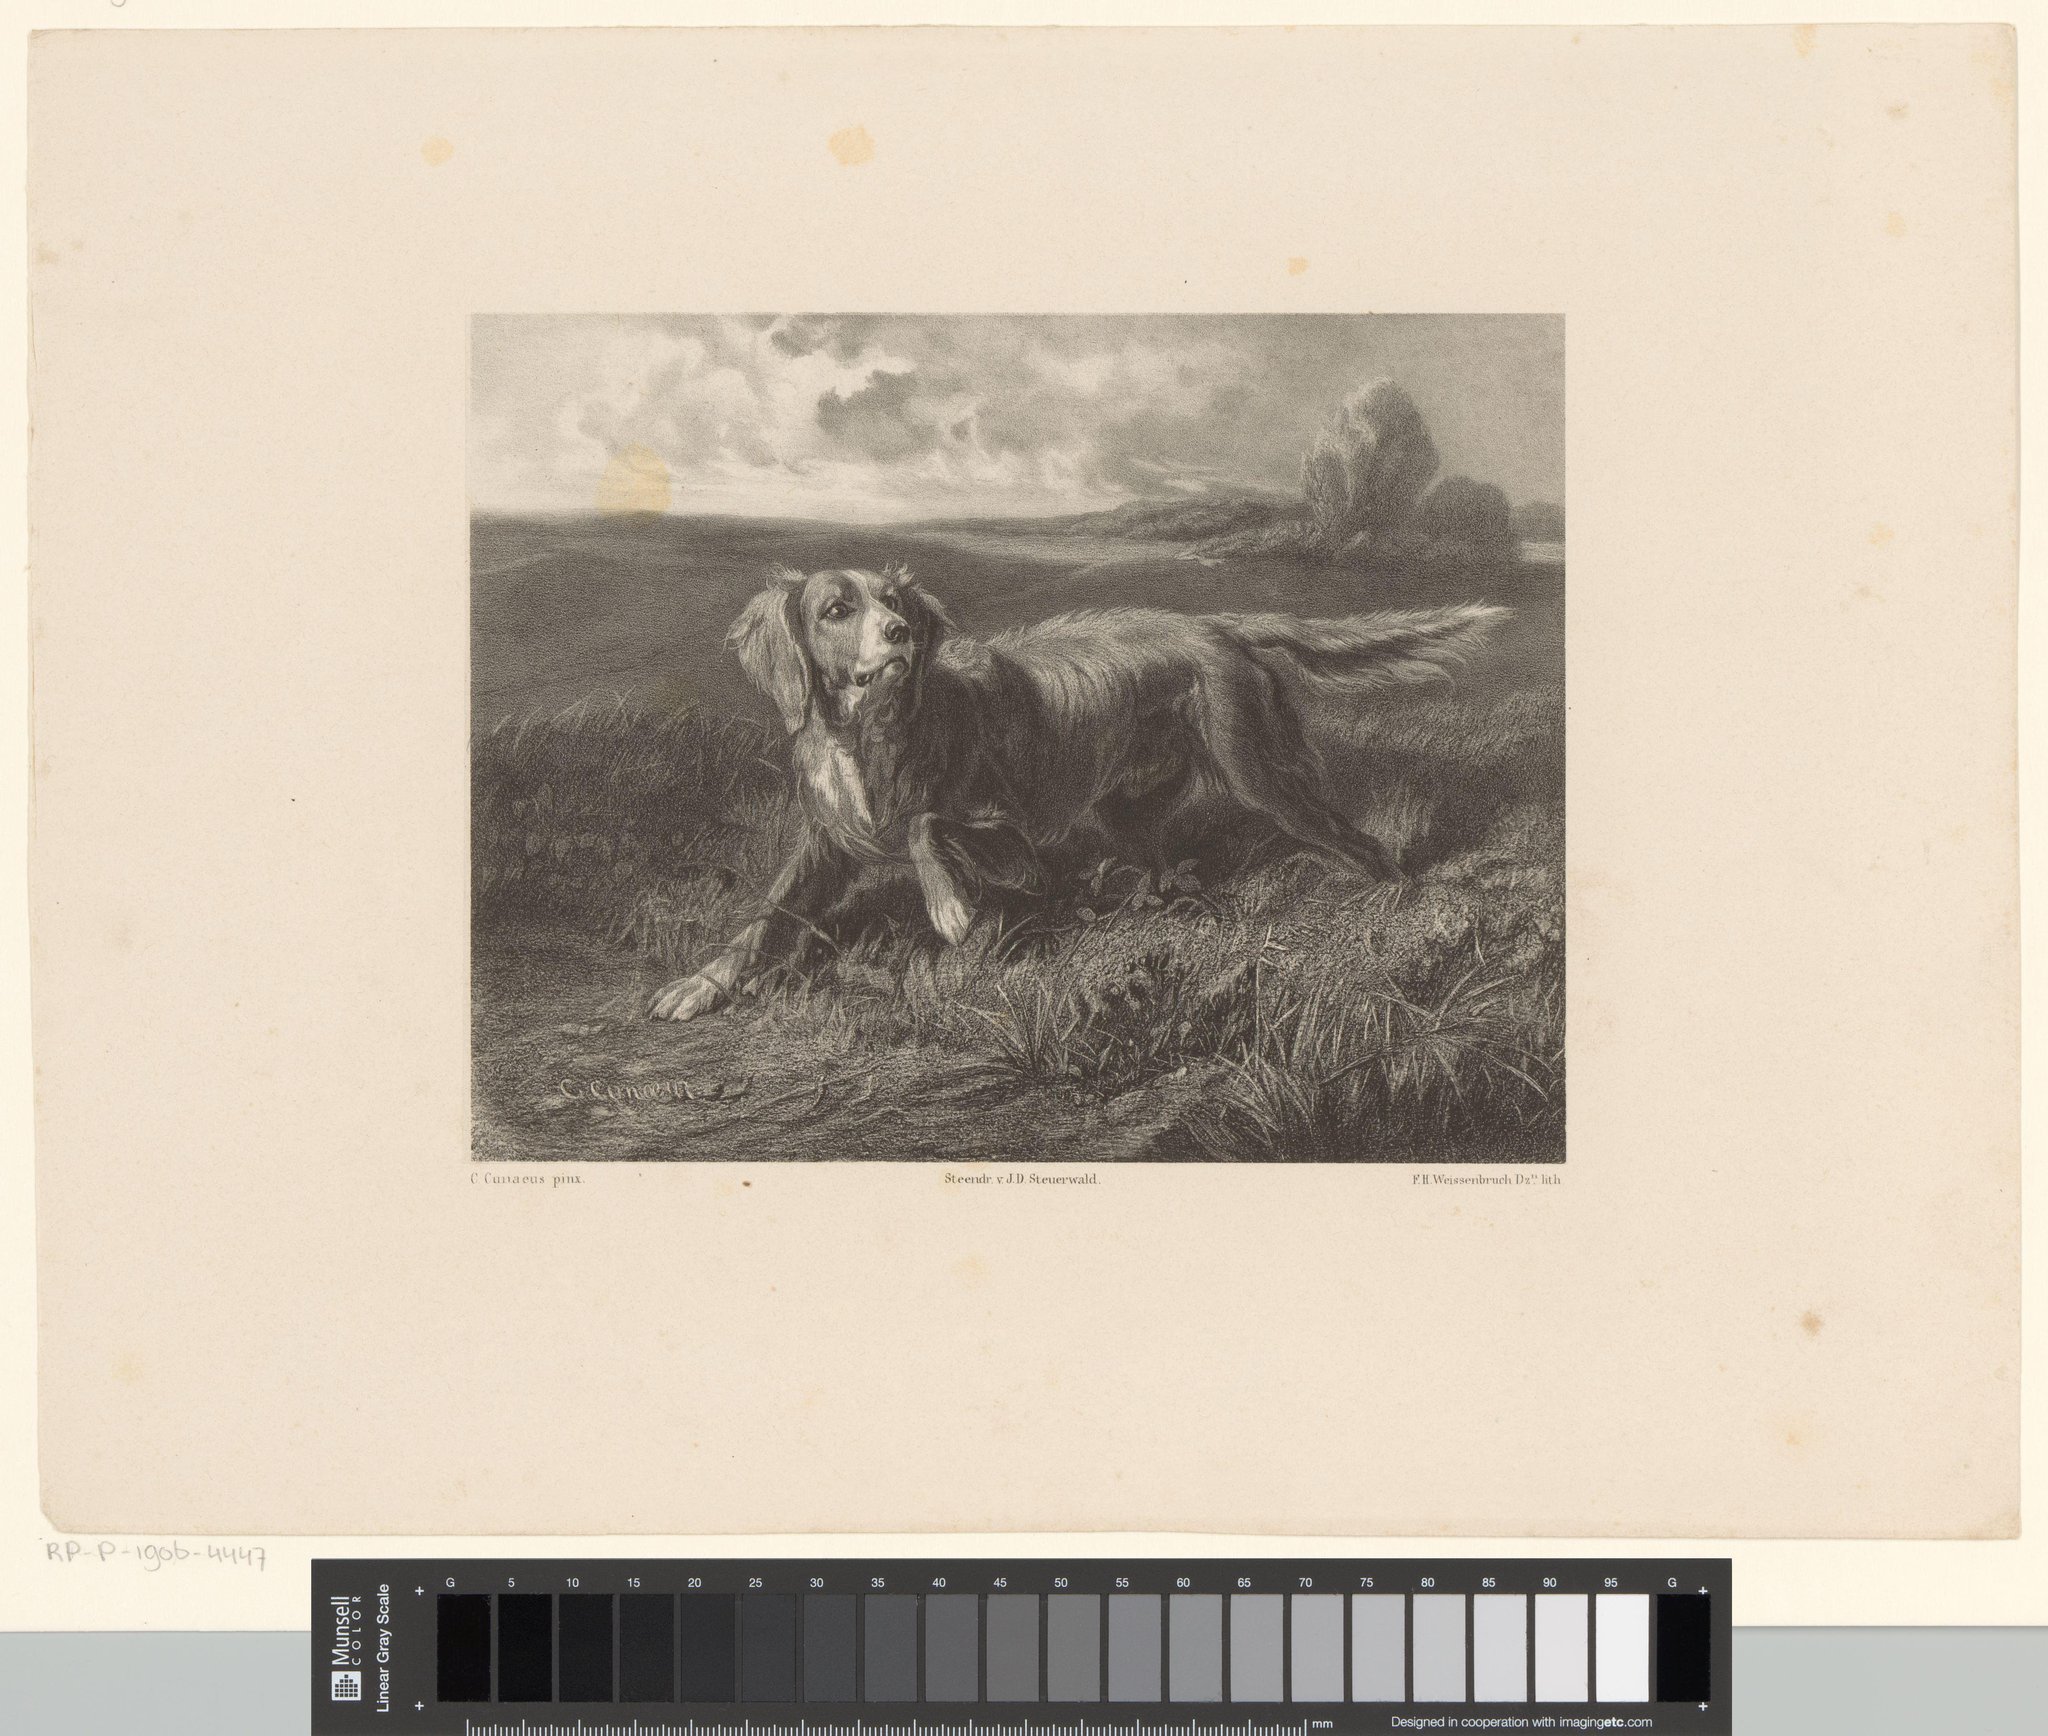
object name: print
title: Hond in landschap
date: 1838-1863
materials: paper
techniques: lithograph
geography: the hague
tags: dog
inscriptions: collector's mark: Lugt 2228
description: De hond kijkt gefixeerd naar rechts en heeft zijn linker voorpoot opgetild.